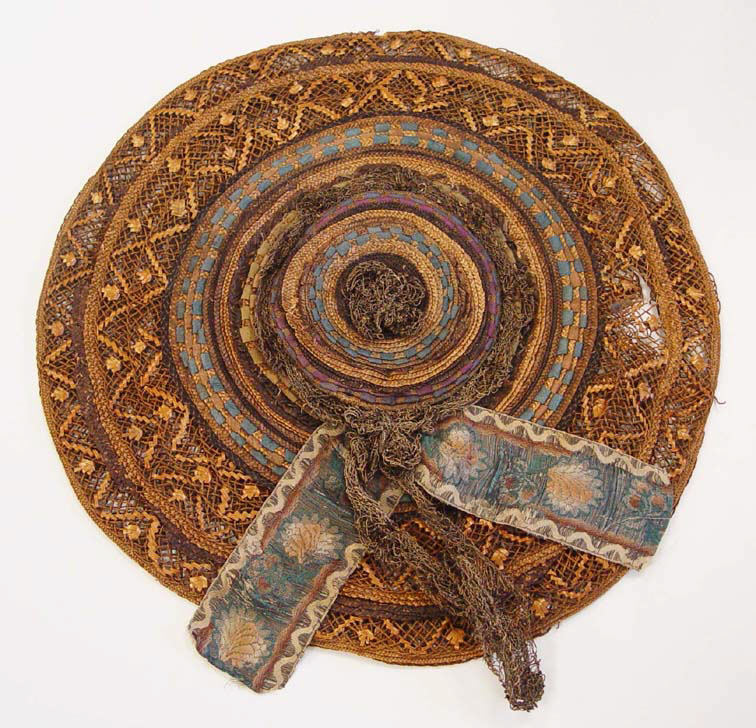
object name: hat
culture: british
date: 1701-1800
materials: fiber